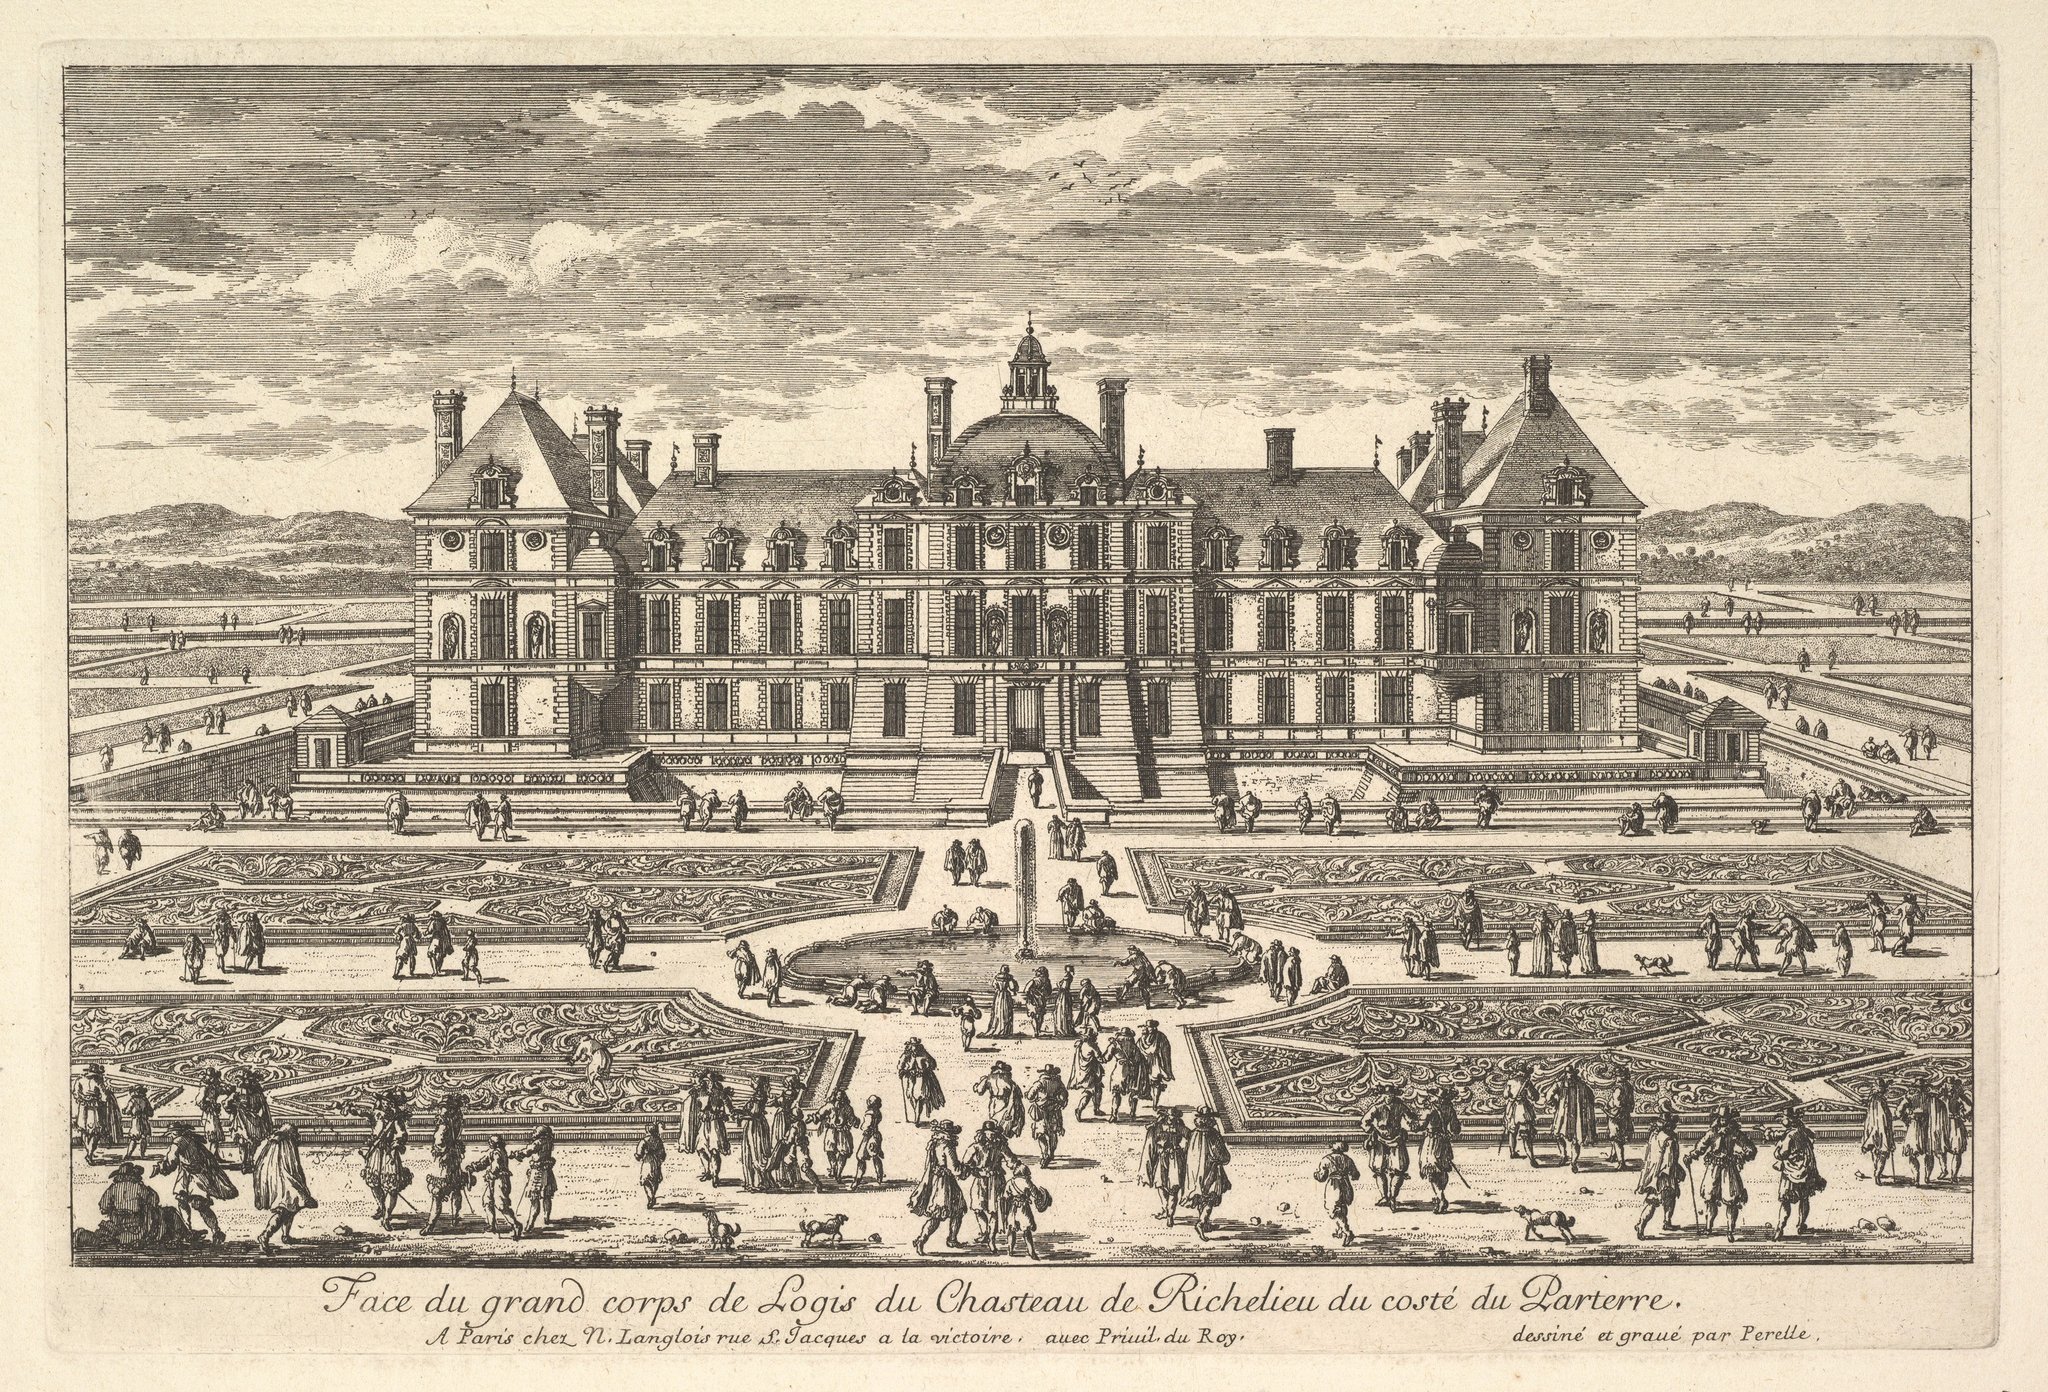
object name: print ornament architecture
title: Face du grand corps de Logis du Château de Richelieu du côté du Parterre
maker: adam perelle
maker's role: artist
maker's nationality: french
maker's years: 1640-1695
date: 1601-1700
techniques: etching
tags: castles,fountains,men,women,dogs